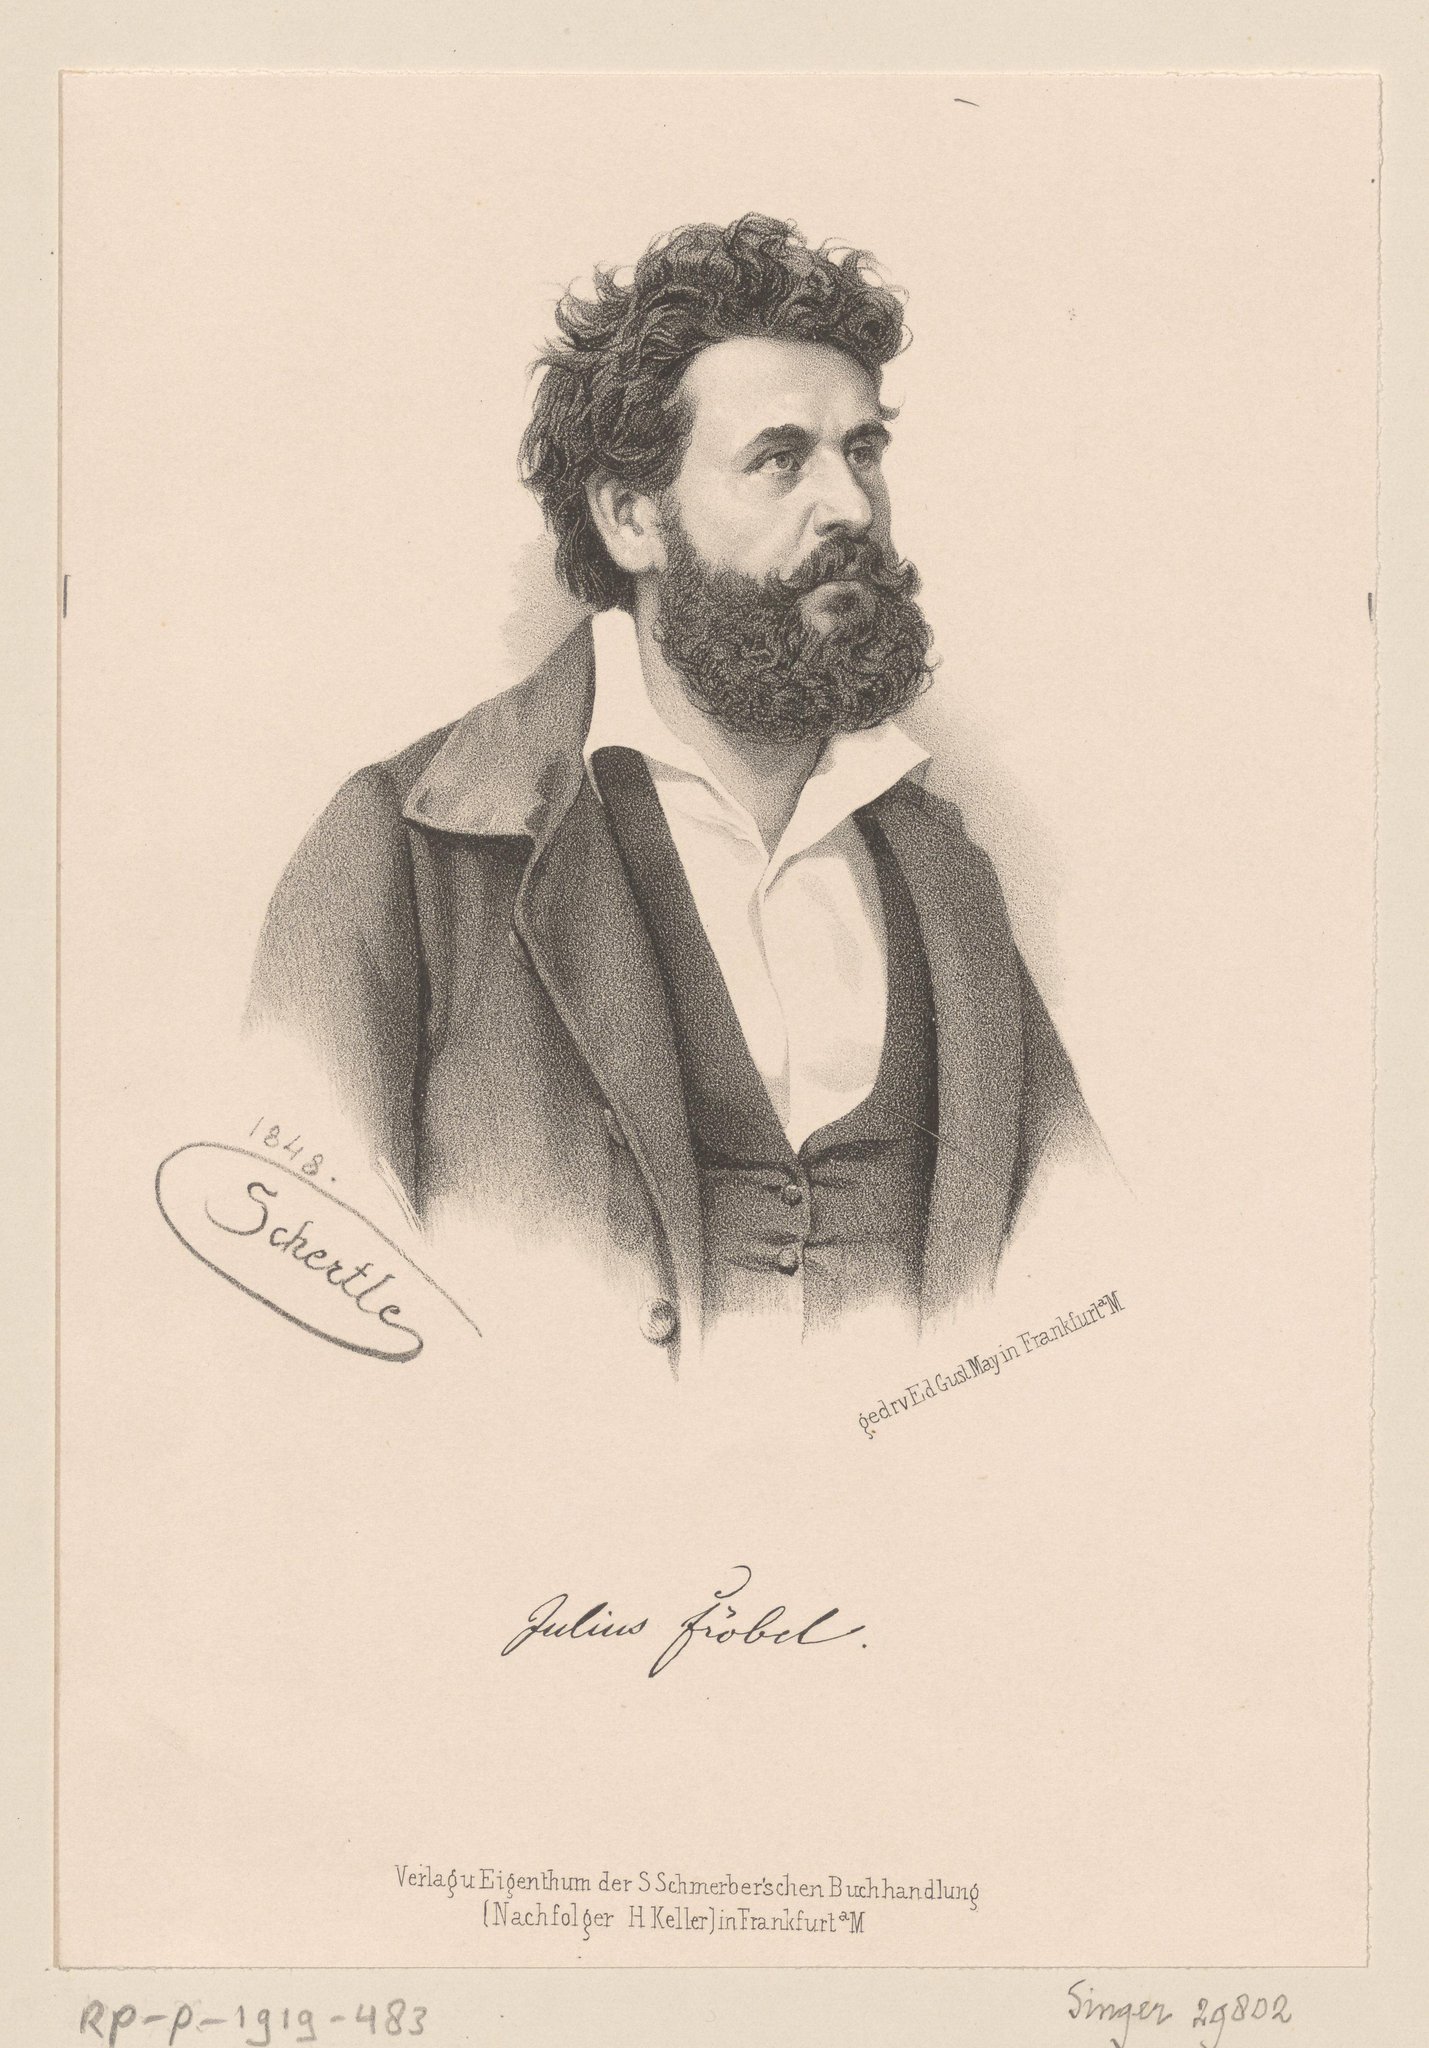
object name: print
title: Portret van Julius Fröbel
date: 1848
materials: paper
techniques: lithograph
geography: frankfurt am main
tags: politician, historical persons, geology (+ portrait of scholar, scientist)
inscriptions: collector's mark: Lugt 2228